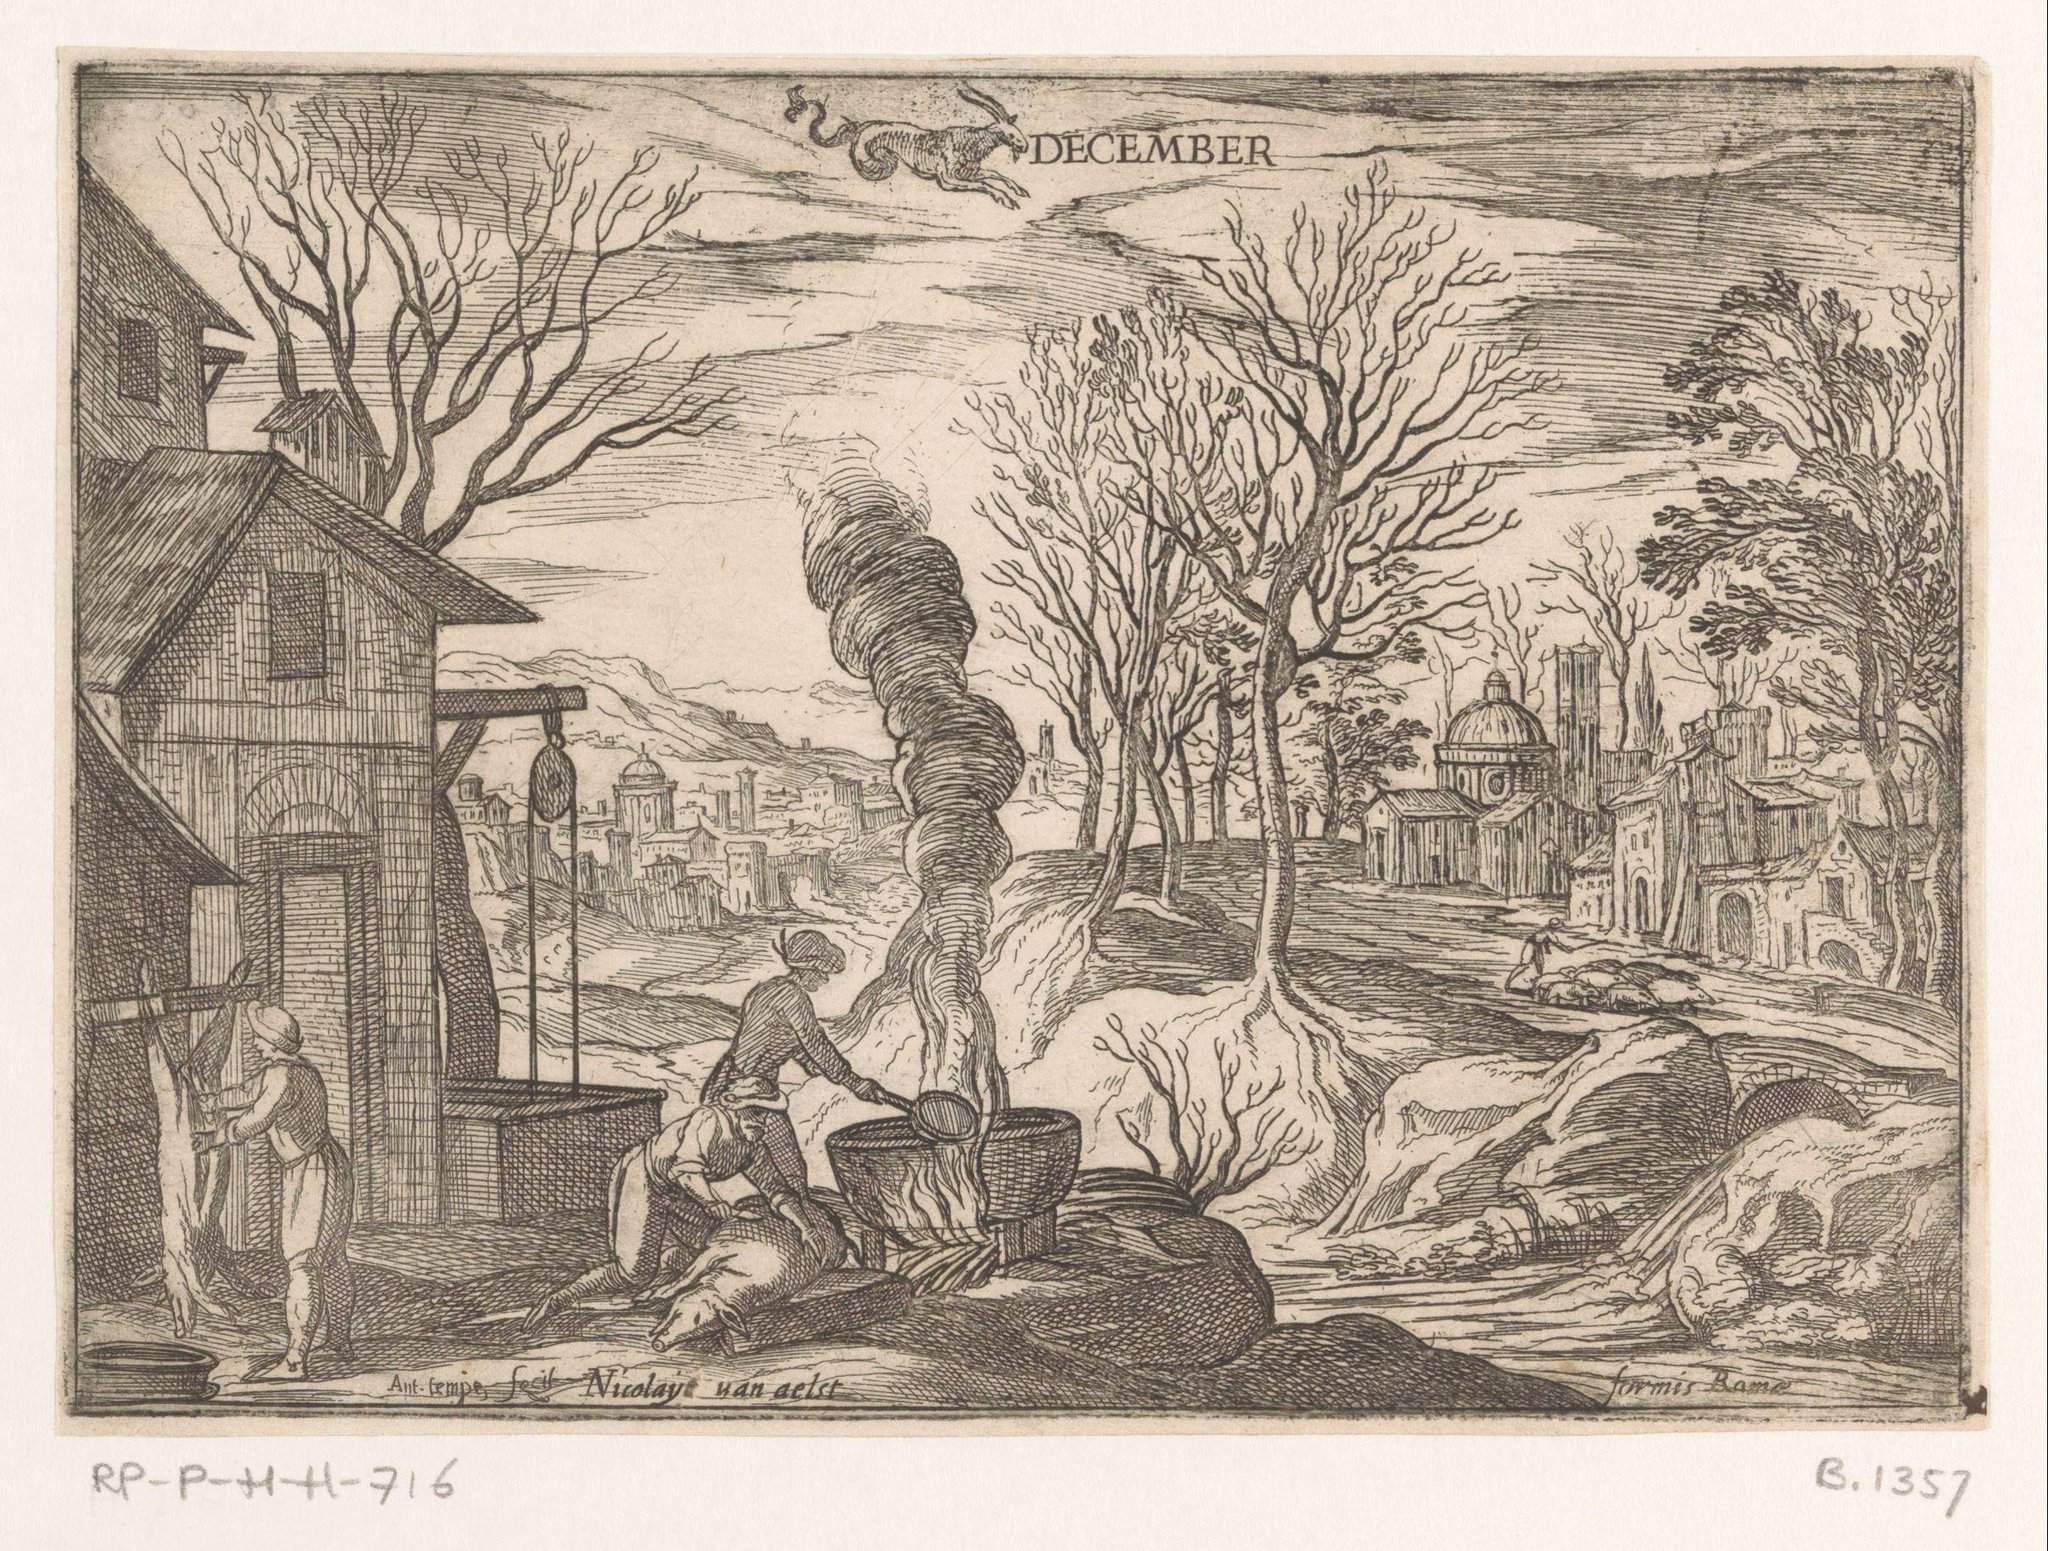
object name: print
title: De twaalf maanden (deel 2)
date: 1575-1613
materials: paper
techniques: etching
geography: rome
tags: landscape symbolizing december, butcher, slaughterman, capricorn (zodiacal sign of december)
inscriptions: number: ‘10’, collector's mark: Lugt 11, collector's mark: ‘Hinloopen’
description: Landschap dat de maand december verbeeldt. Landschap met mensen die een varken slachten. Midden boven het symbool voor het sterrenbeeld steenbok.